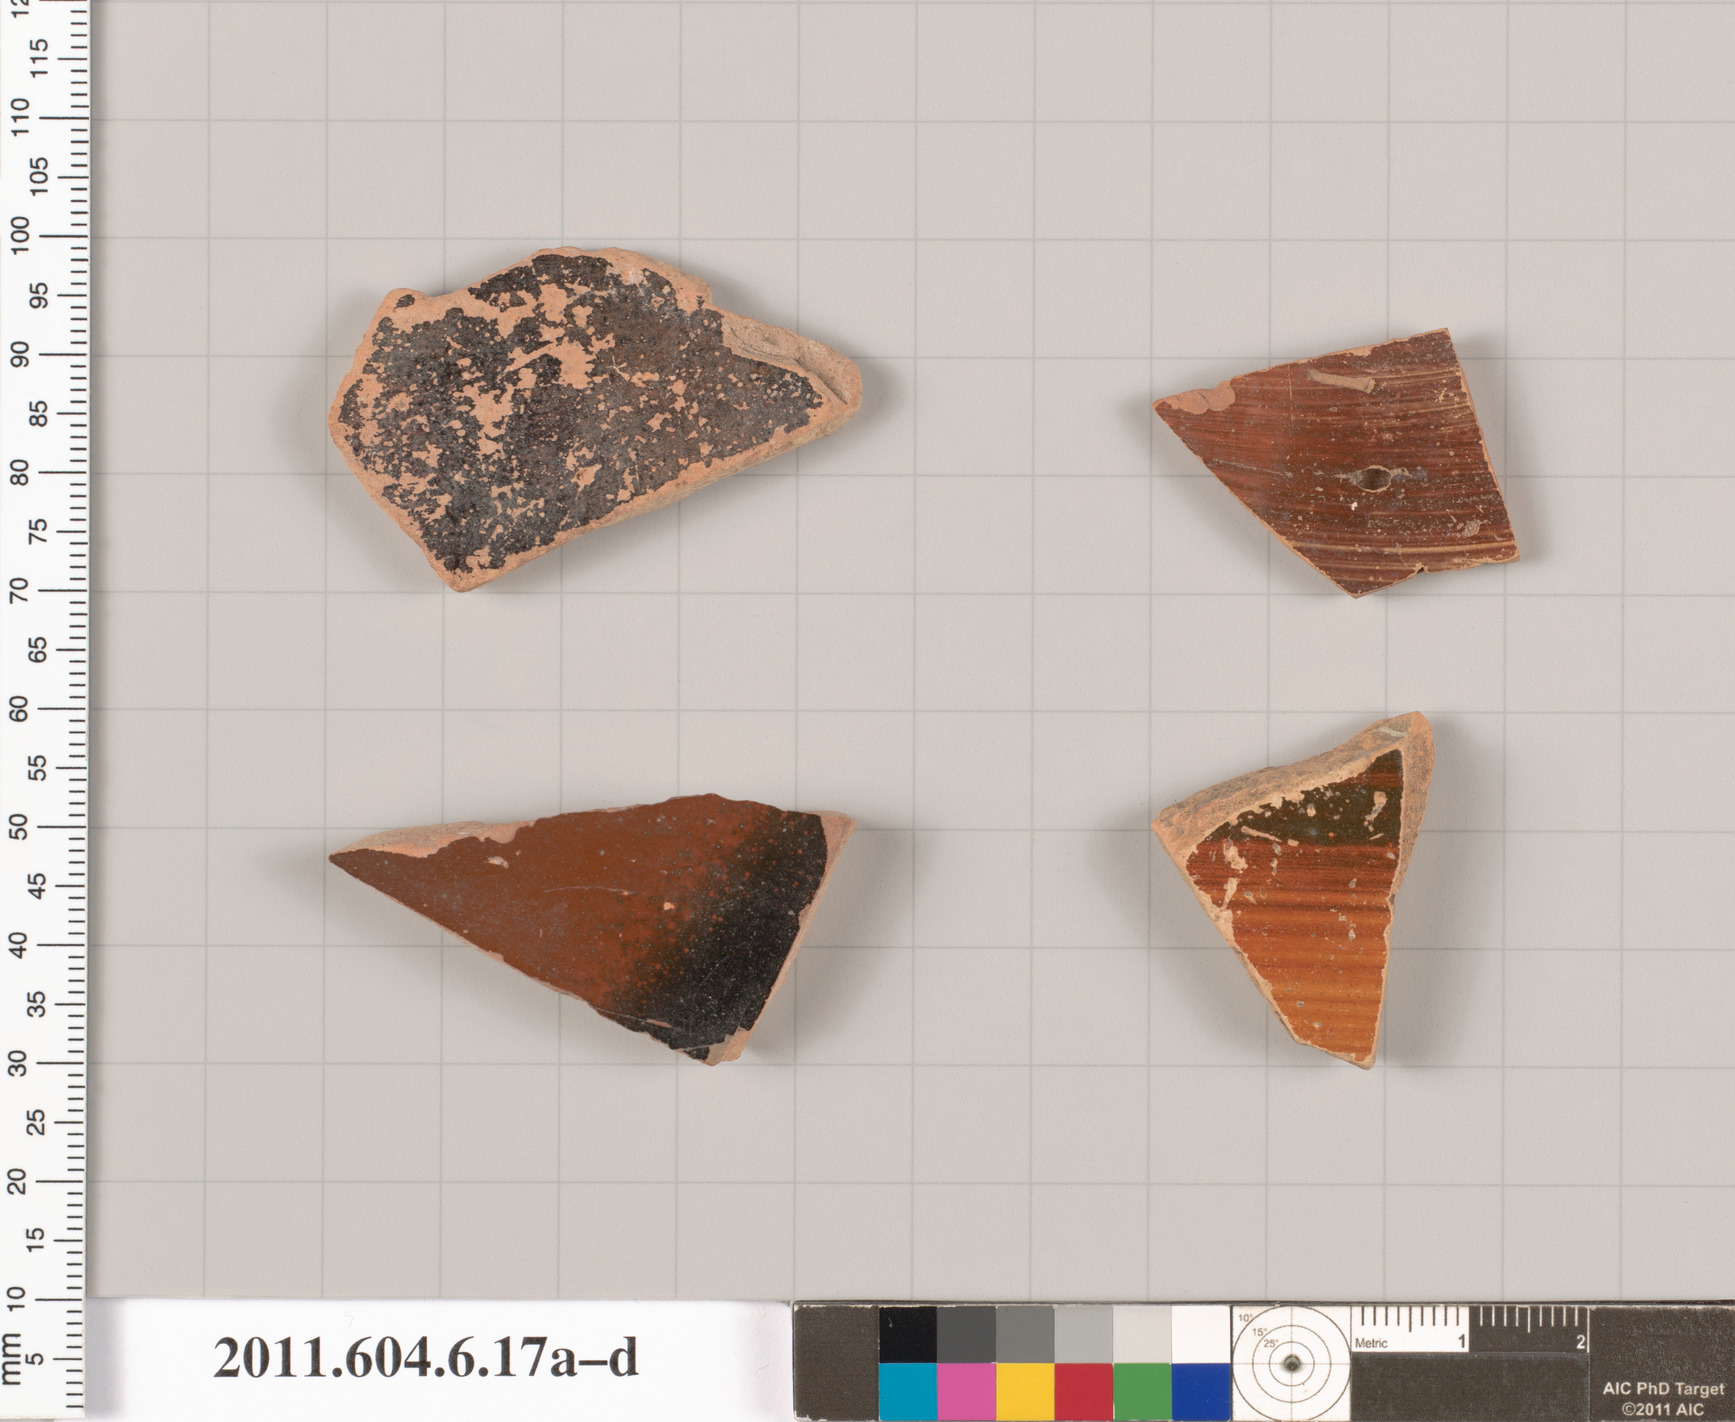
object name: undetermined closed shape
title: Terracotta fragments of closed shapes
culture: greek, attic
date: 600-401 BCE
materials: terracotta